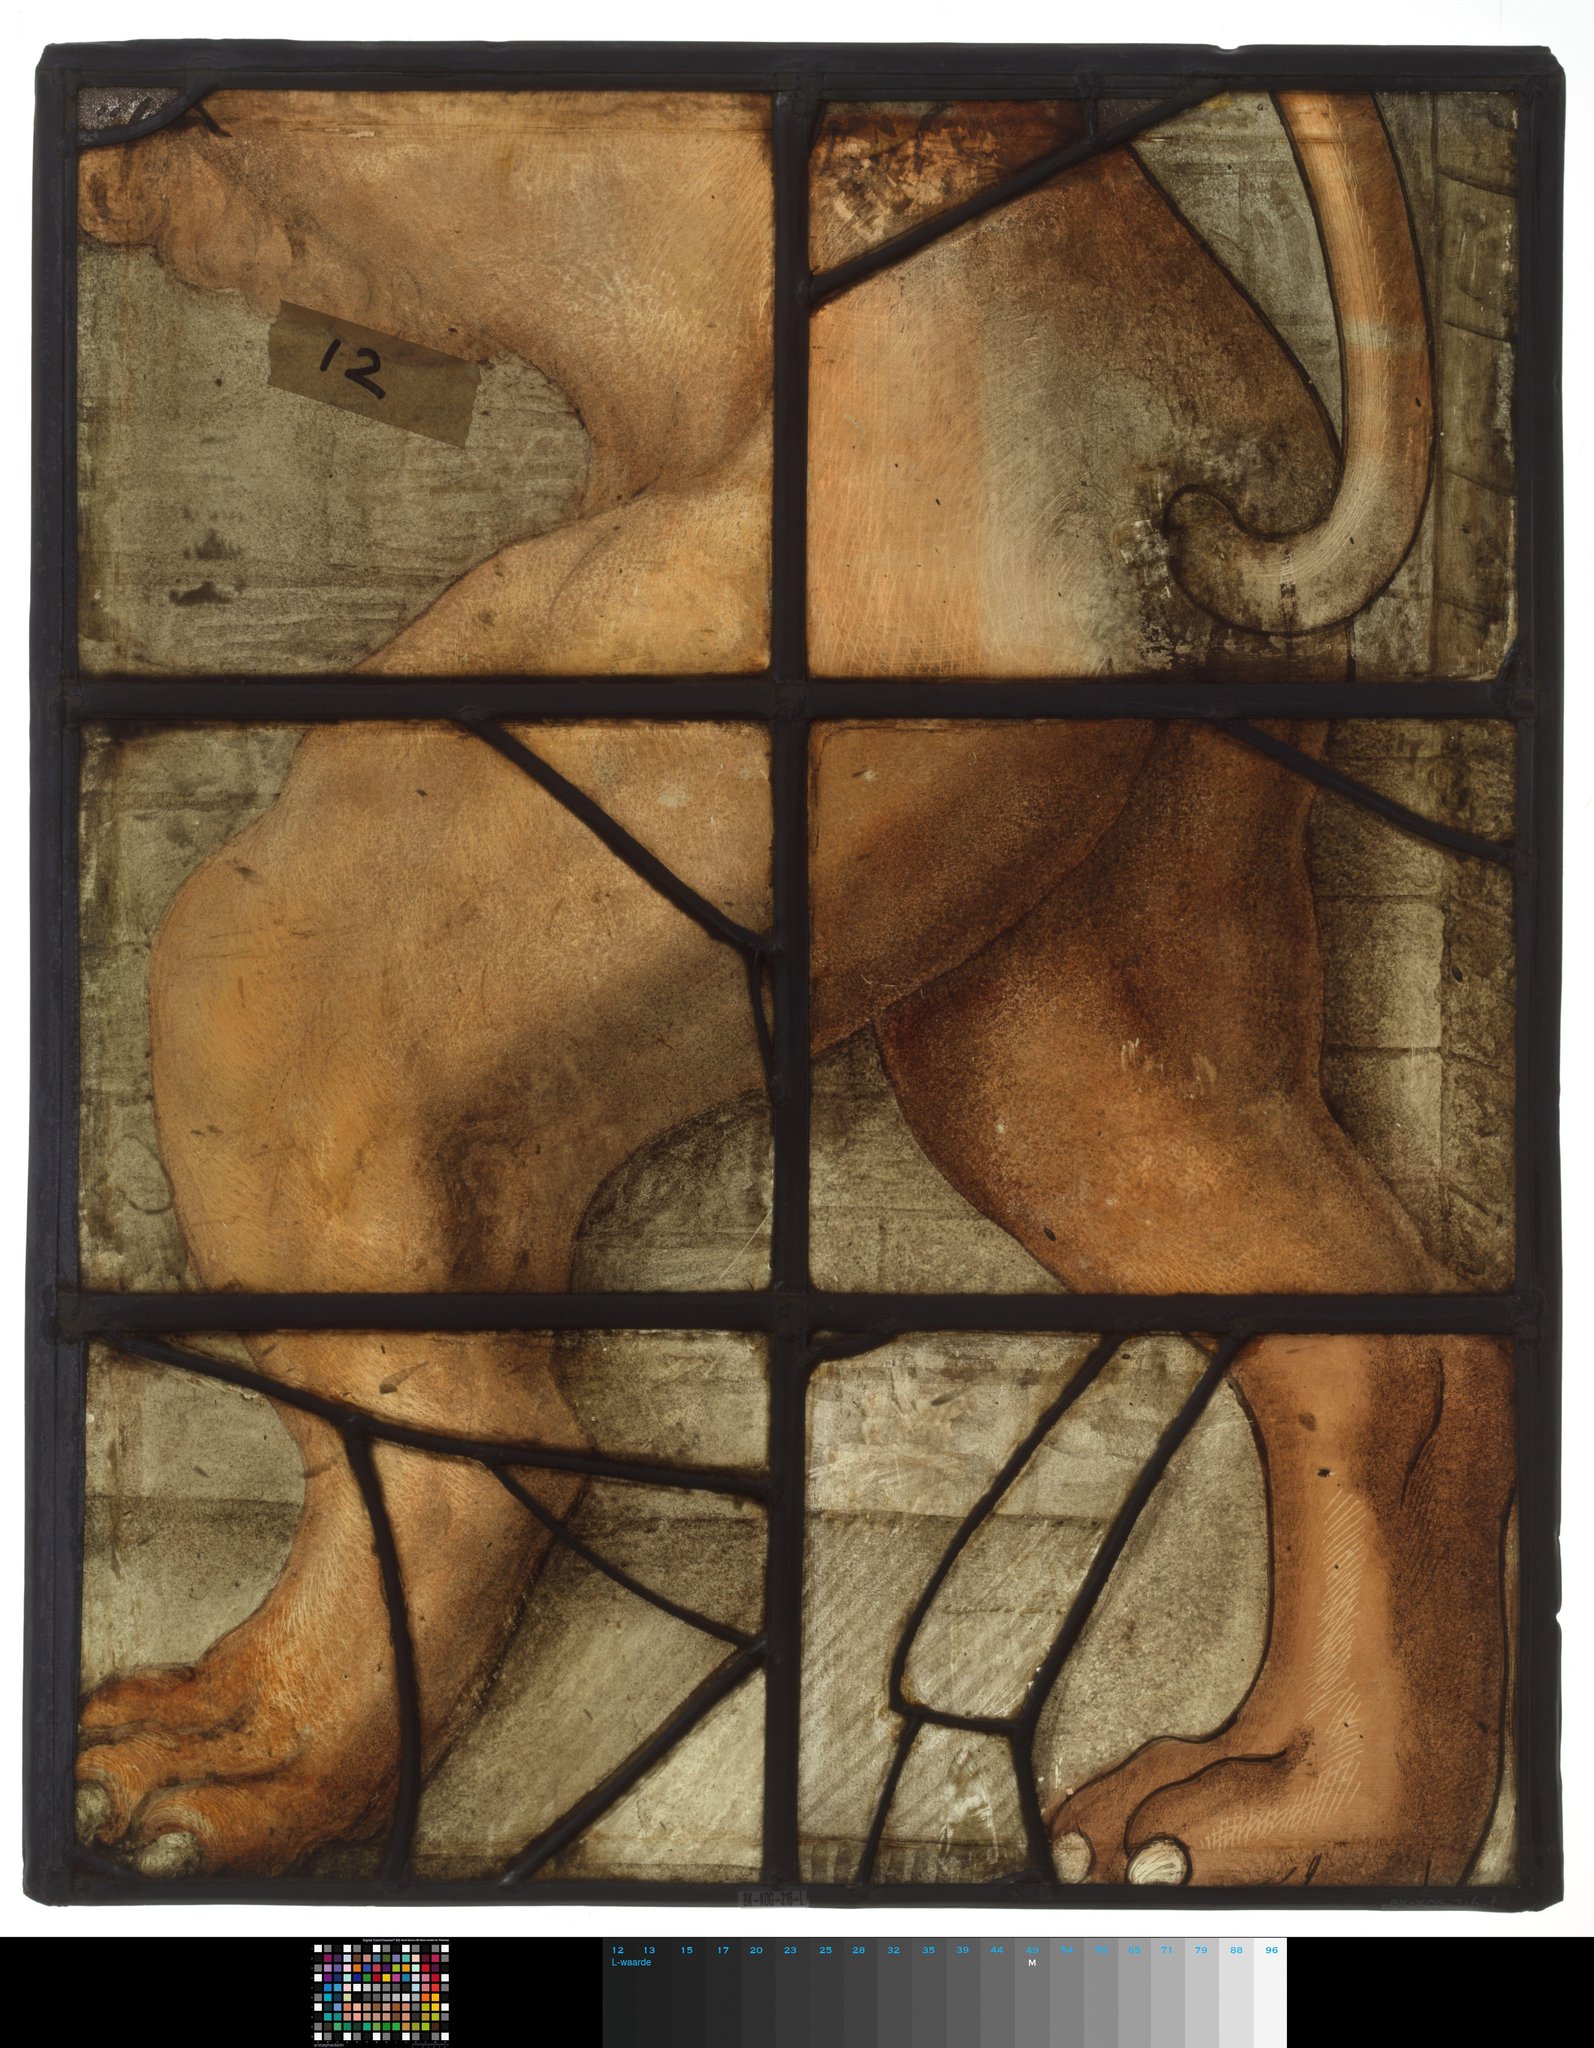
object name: light window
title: Ruit met het wapen van Alkmaar met onderschrift "Alkmaria Victrix 1573"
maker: Anonymous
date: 1573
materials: glass, lead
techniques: leading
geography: netherlands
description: Ruit, glas-in-lood, bestaande uit zestien afzonderlijke panelen die tezamen het wapen van Alkmaar laten zien. Onderschrift: ALKMARIA VICTRIX. Gedateerd 1573.